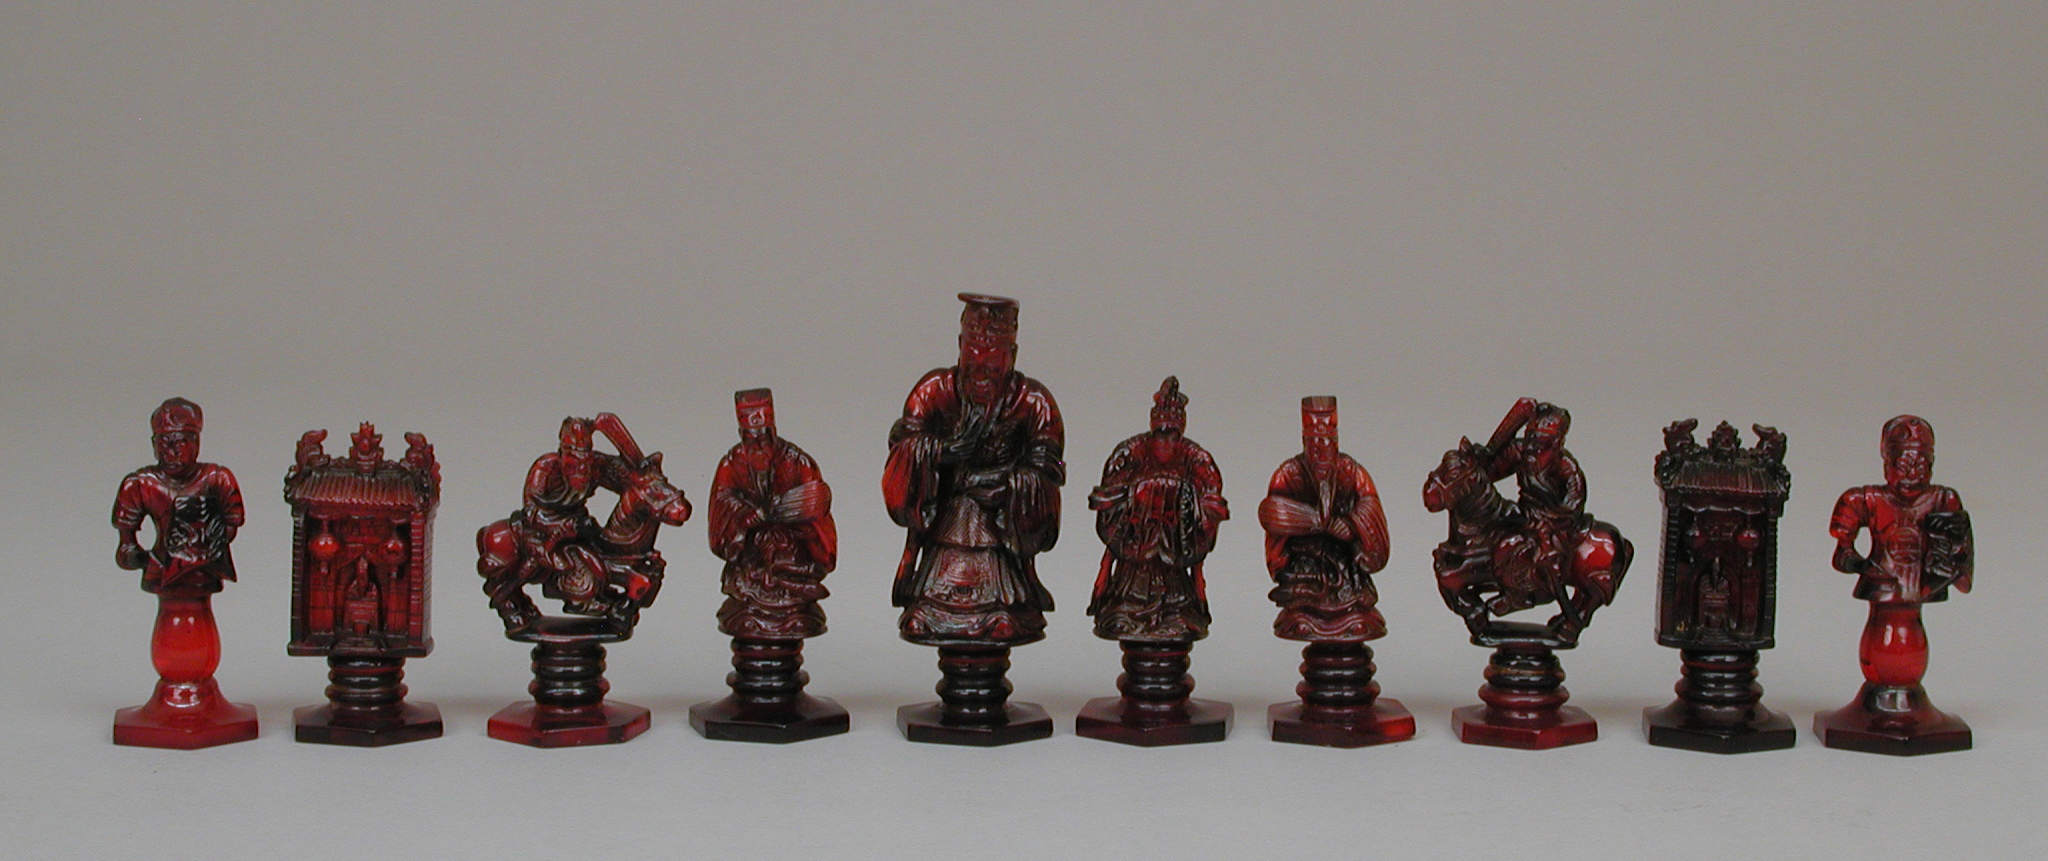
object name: chessman and board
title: Chessmen (32) and board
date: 1801-1900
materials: amber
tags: chess